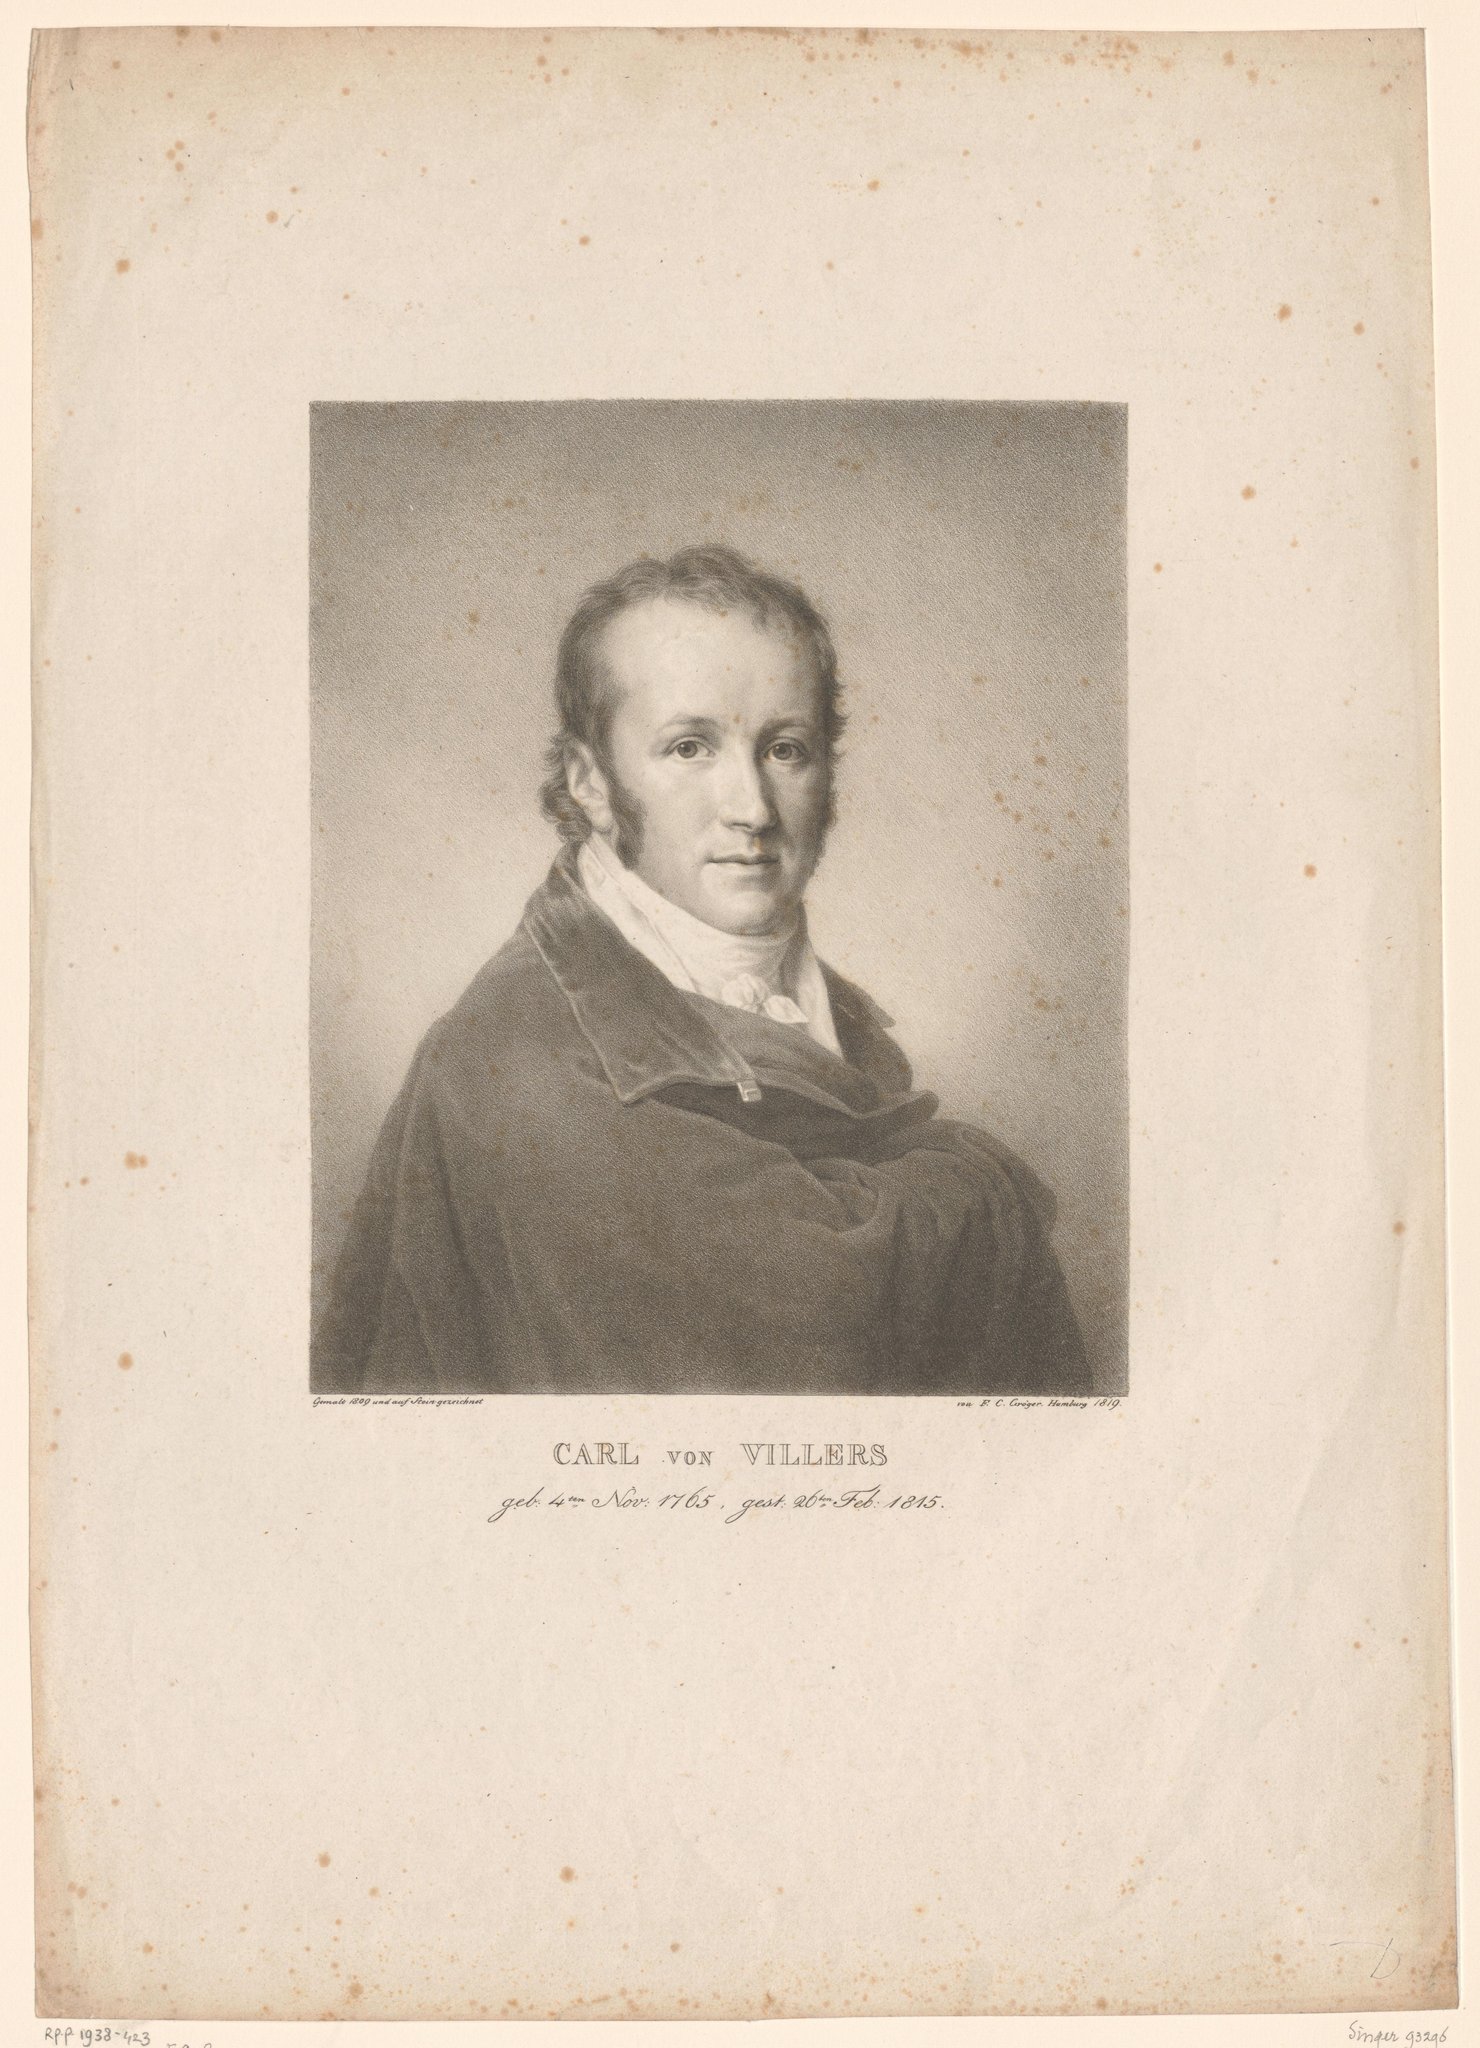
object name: print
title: Portret van Charles de Villers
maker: friedrich carl gröger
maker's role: draughtsman, painter, print maker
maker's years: 1766-1838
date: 1819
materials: paper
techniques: lithograph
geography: hamburg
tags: adult man, historical persons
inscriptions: collector's mark: Lugt 2228